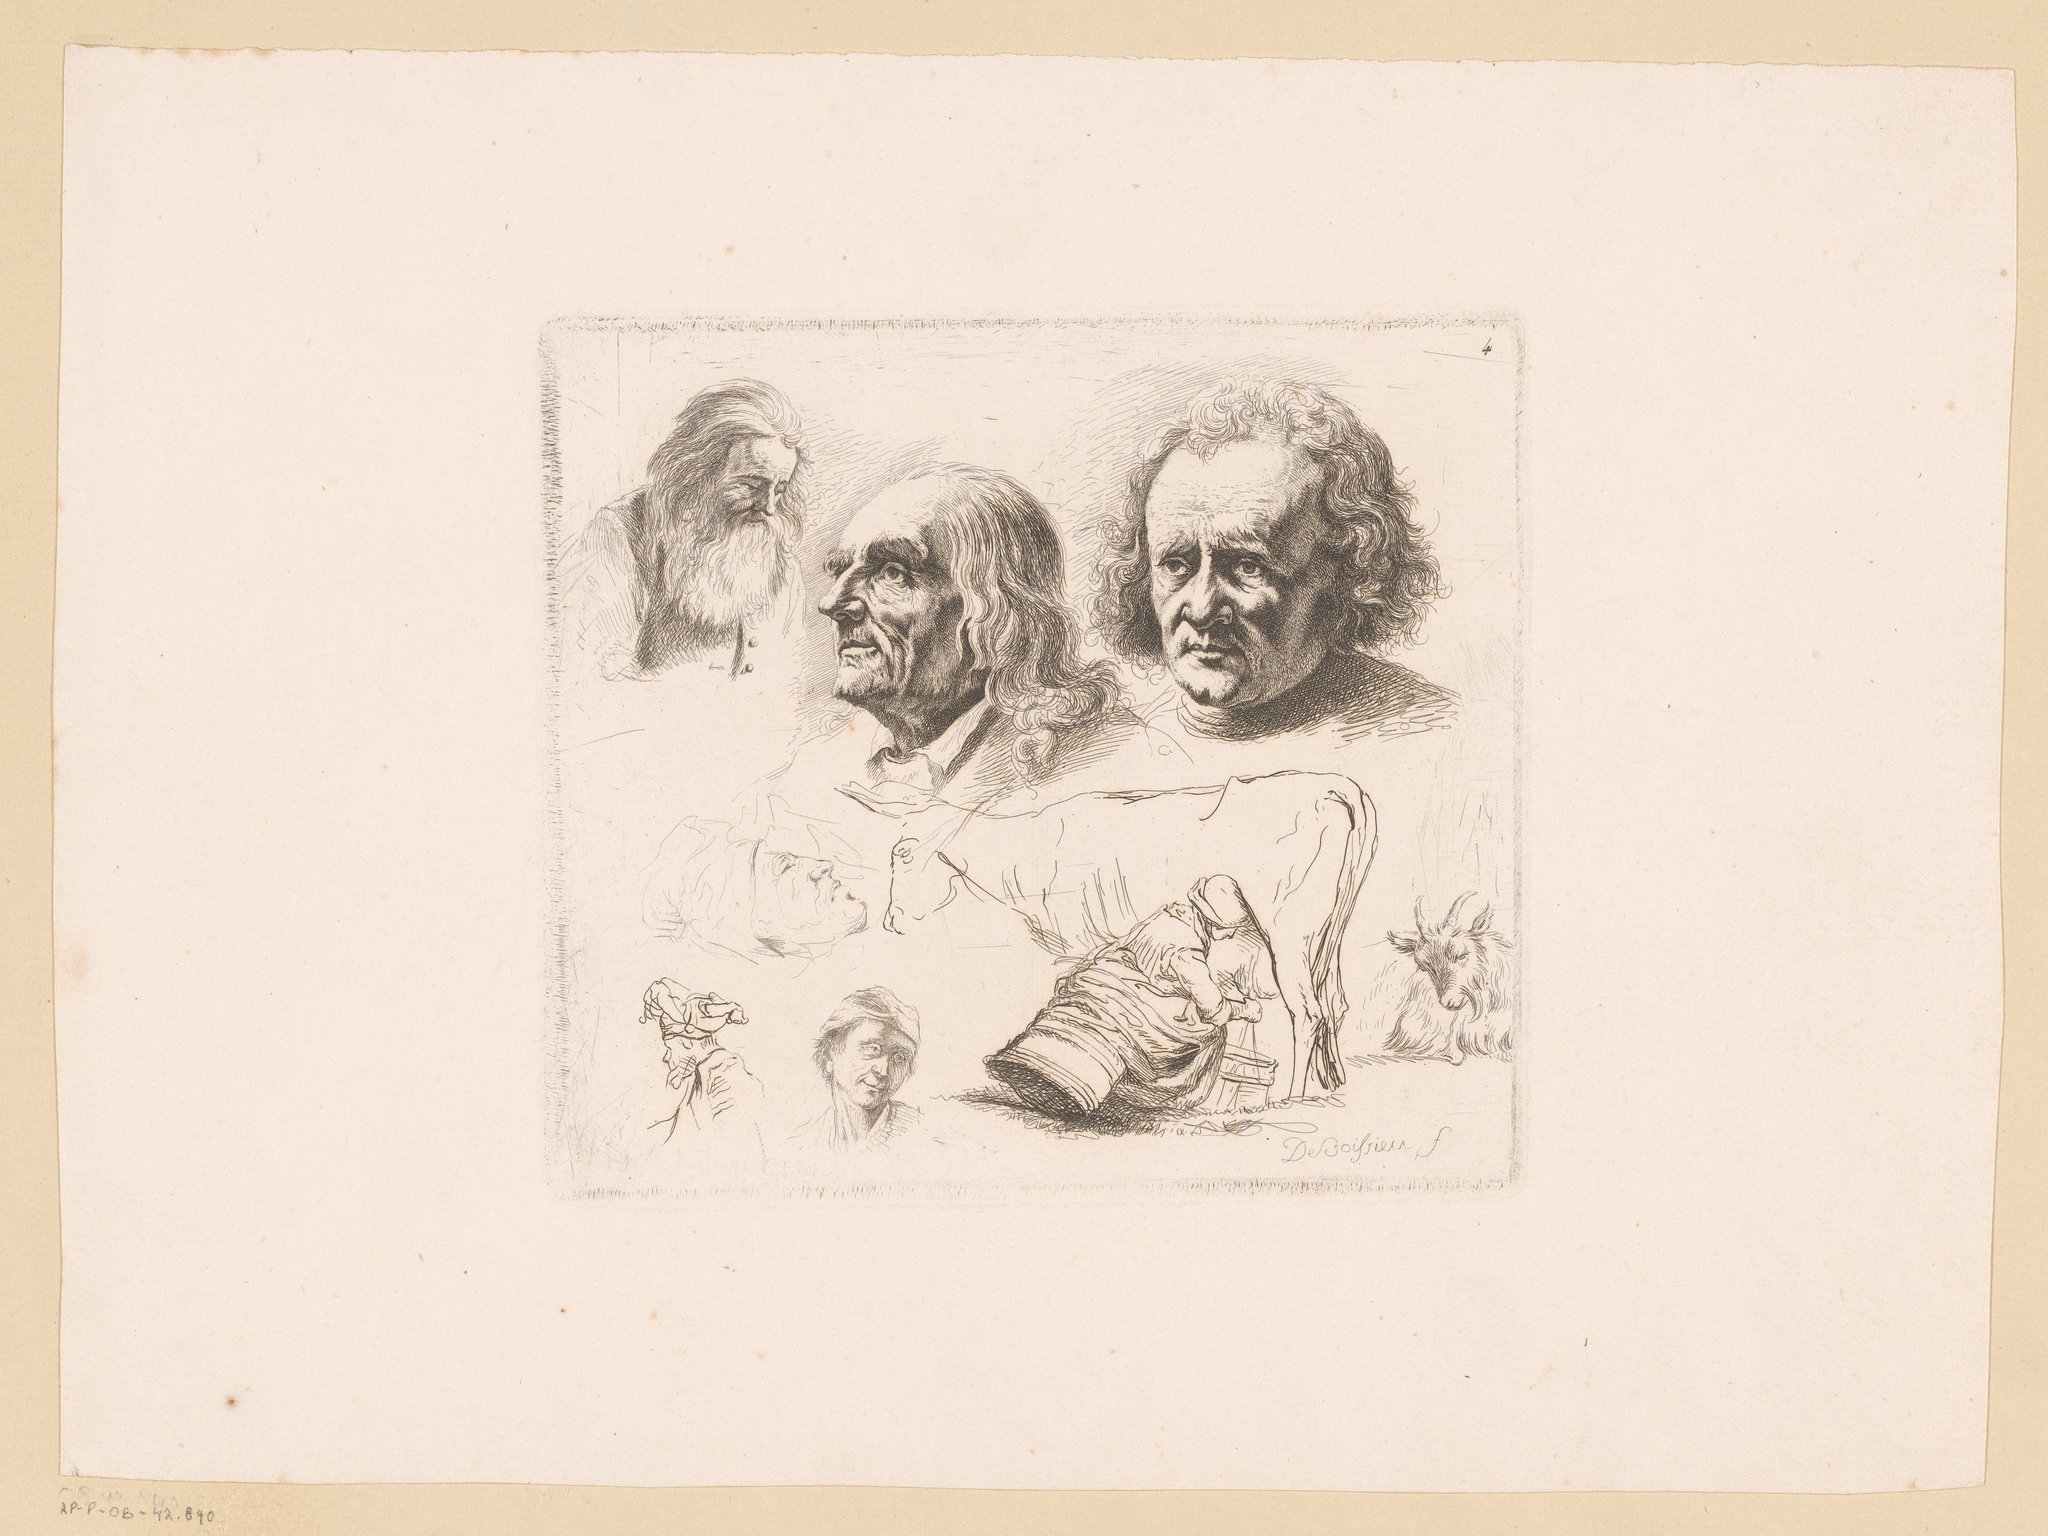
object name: print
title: Compositie met koe, bok en zes hoofden van mannen van verschillende leeftijden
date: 1805-1844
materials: paper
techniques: engraving, etching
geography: france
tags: old man, milkmaid, milking